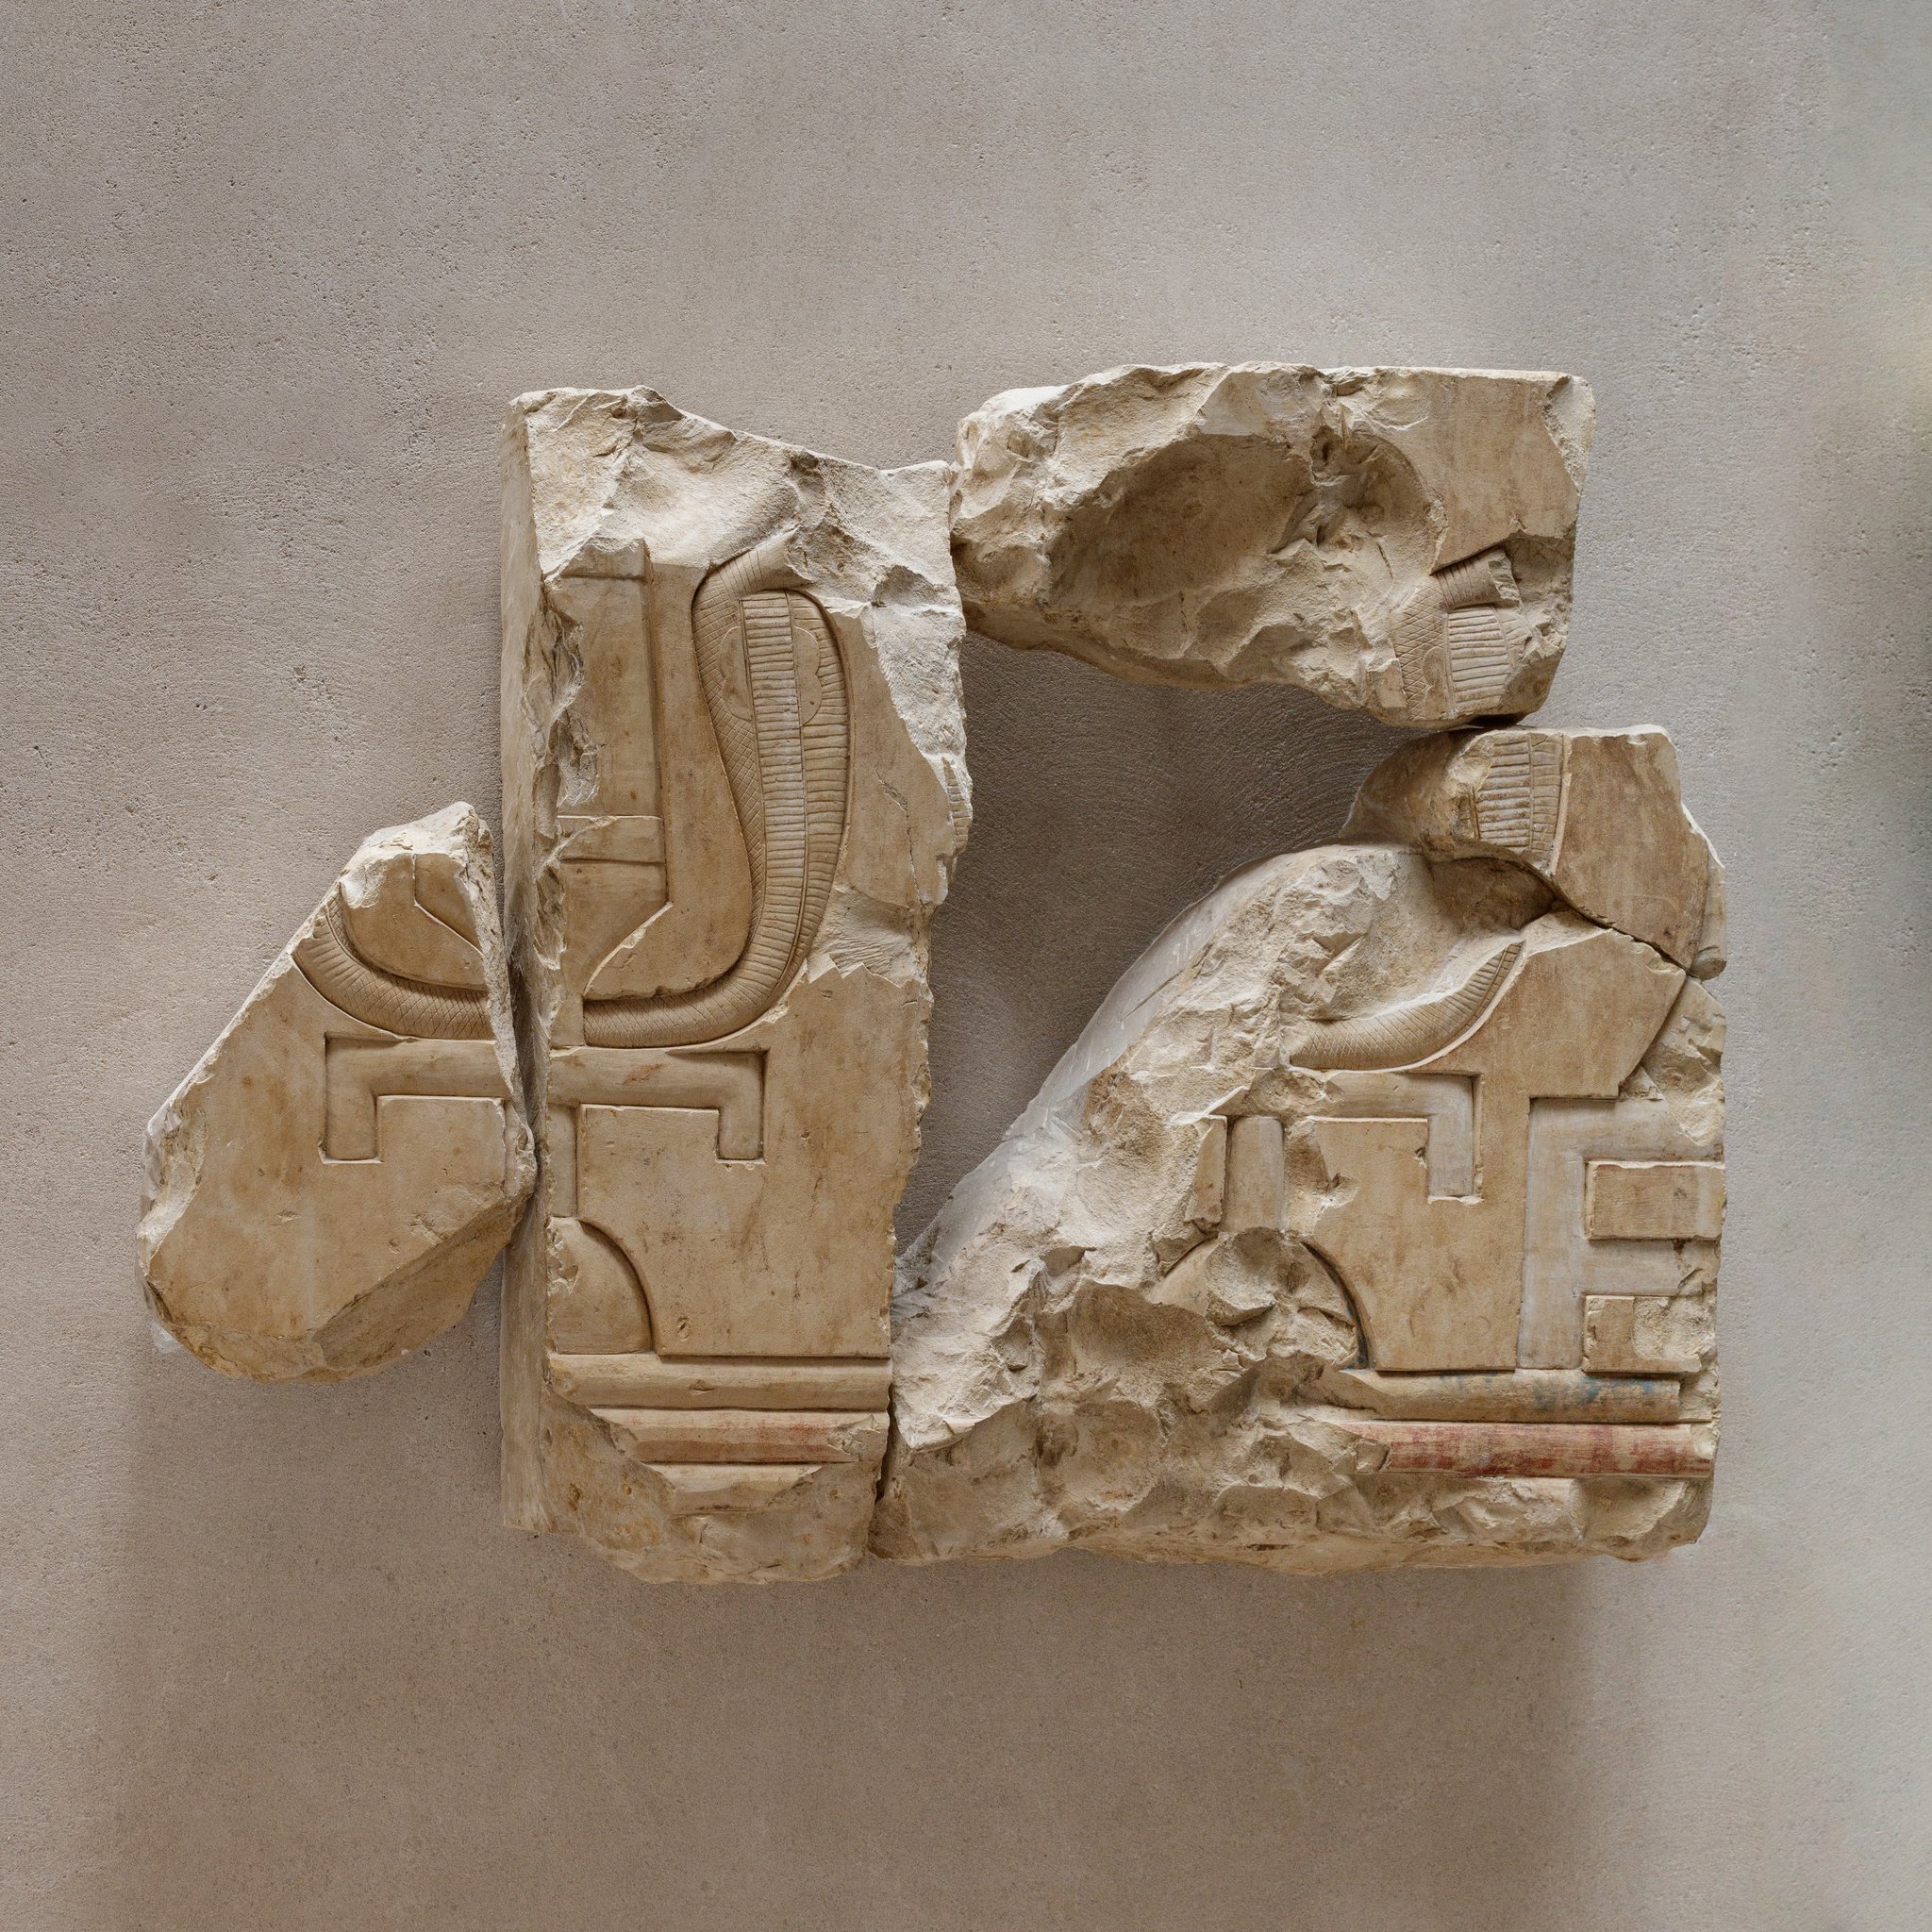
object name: relief, two sacred emblem, neferu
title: Relief fragments of two sacred emblems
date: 2051-2030 BCE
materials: limestone, paint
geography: egypt